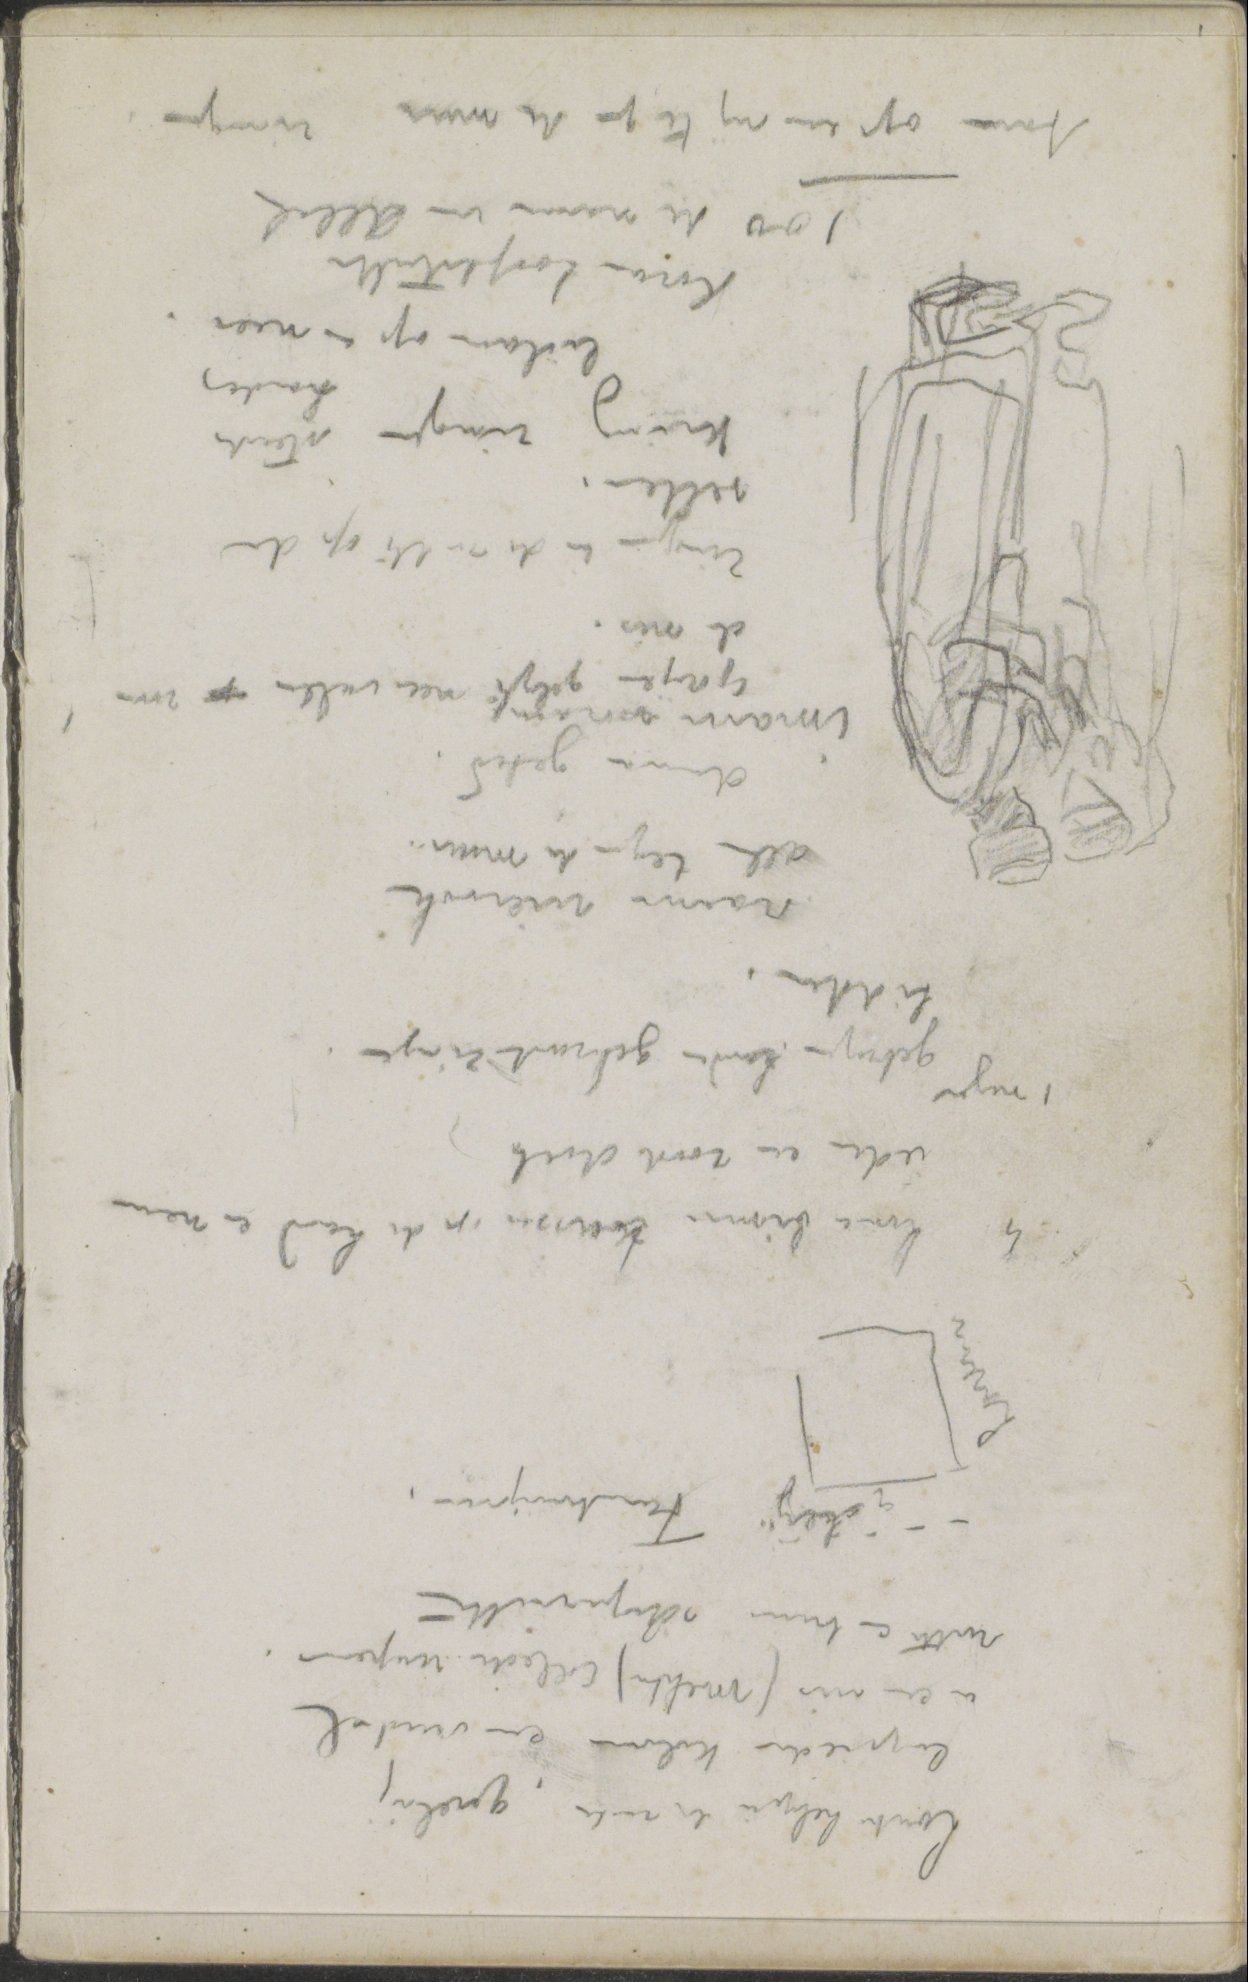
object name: sketchbook leaf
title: Figuur in oosterse kleding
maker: marius bauer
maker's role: draughtsman, print maker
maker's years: 1867-1932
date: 1896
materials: chalk, paper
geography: istanbul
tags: asiatic races and peoples, standing figure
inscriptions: annotation: ‘[...]’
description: Pagina 1 uit een schetsboek met 53 bladen.